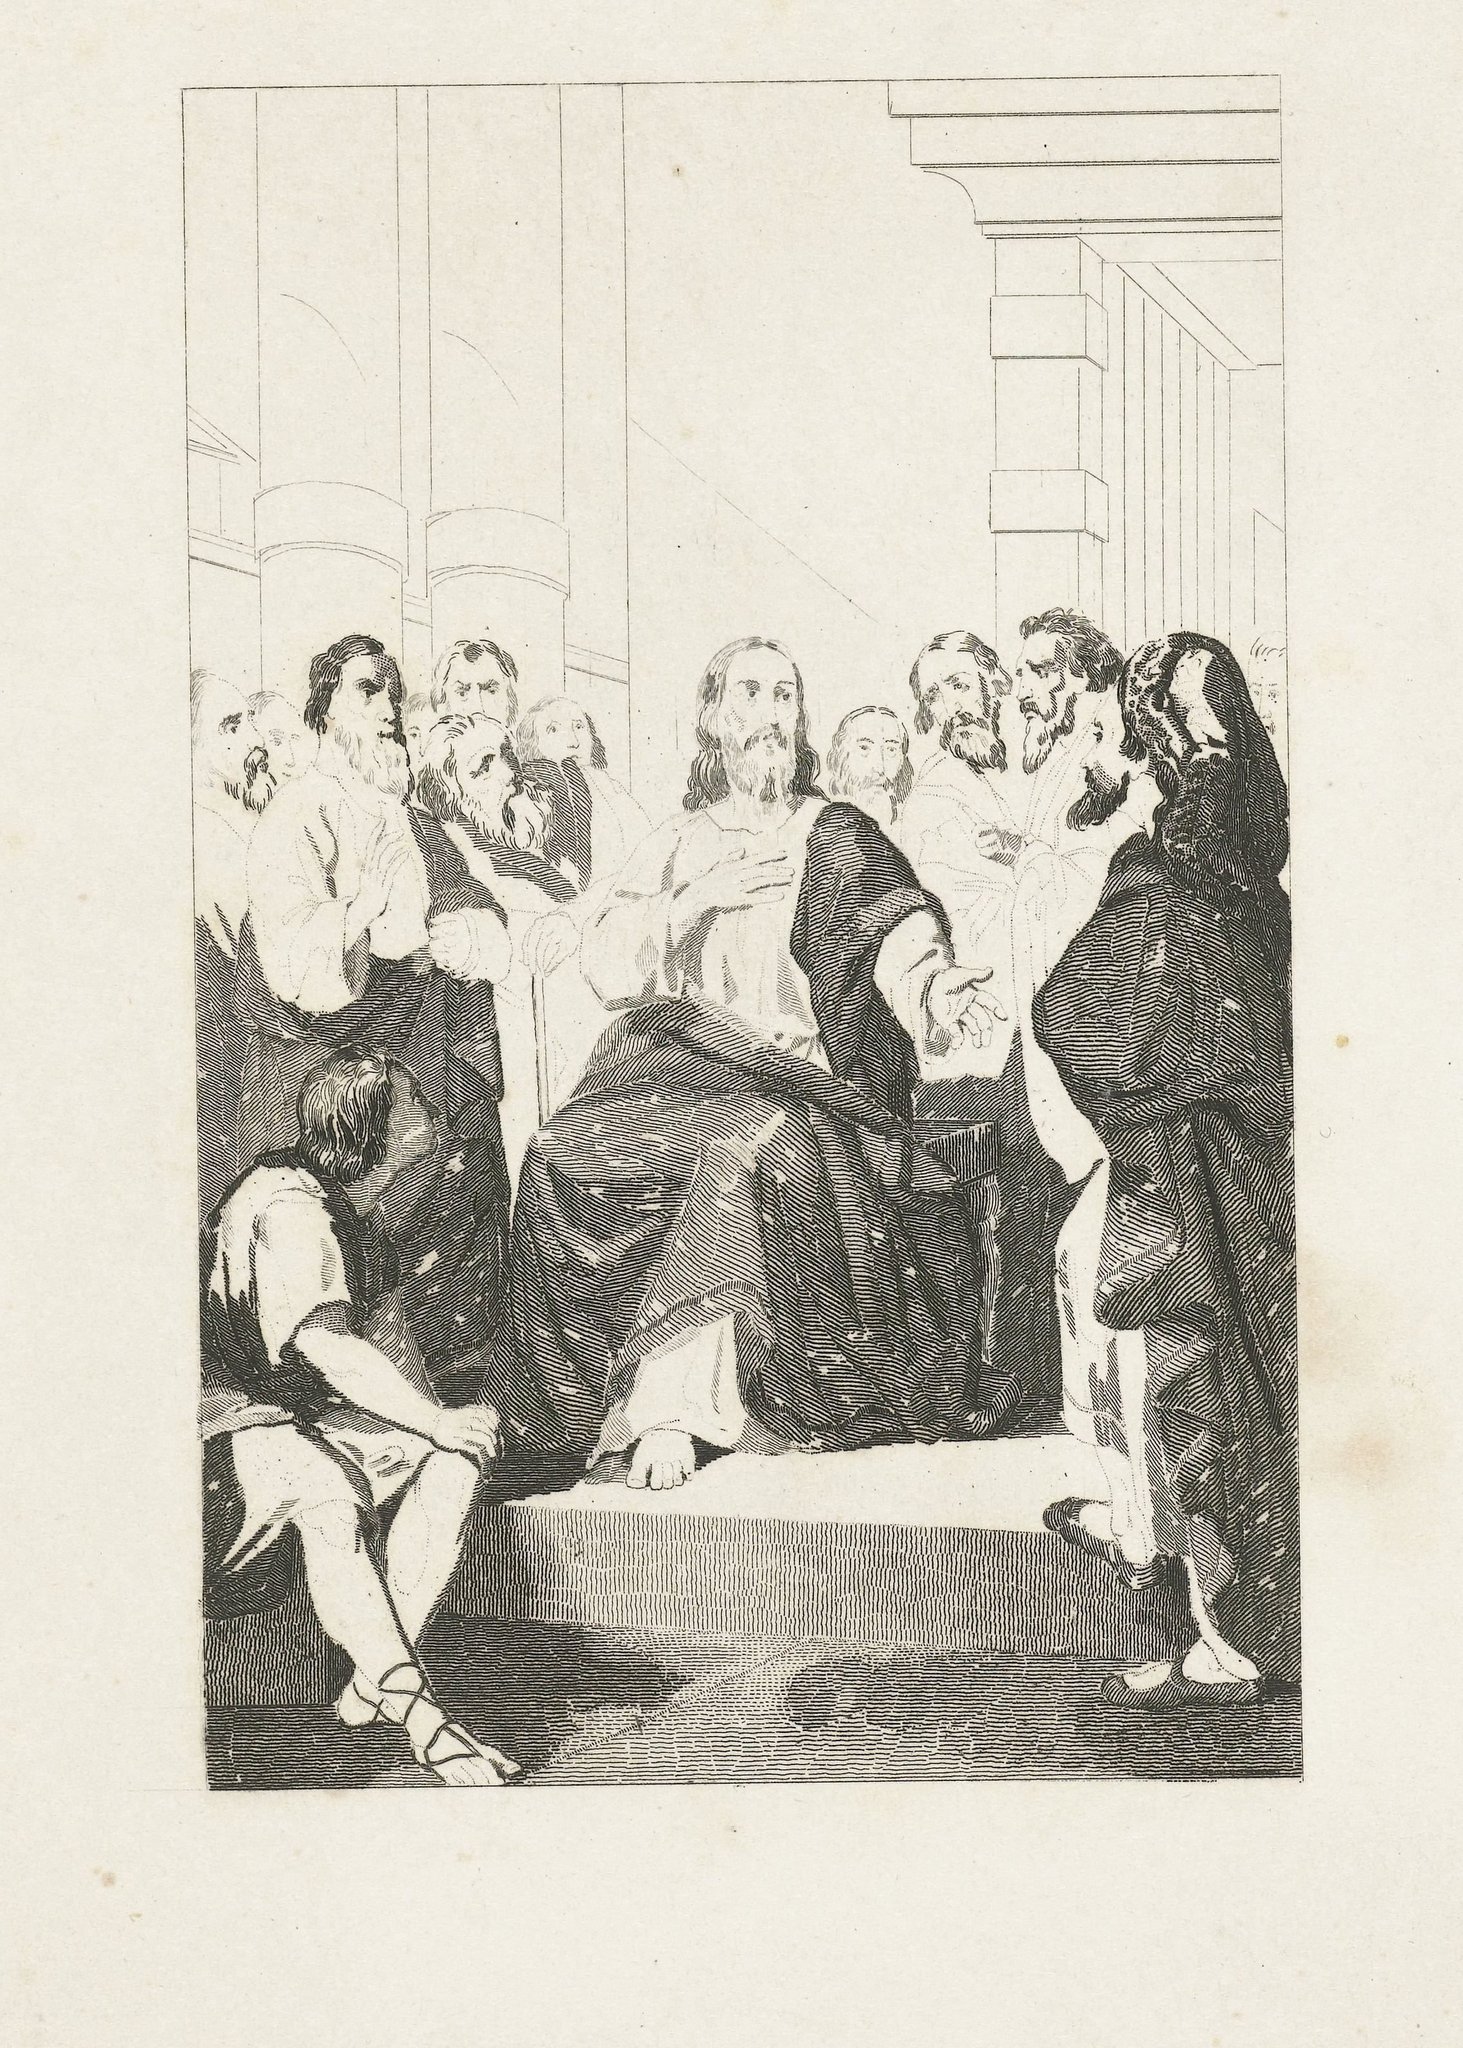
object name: print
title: Christus disputeert met mannen in de tempel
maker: henricus wilhelmus couwenberg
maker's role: draughtsman, print maker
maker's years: 1814-1845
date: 1830-1840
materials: paper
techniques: engraving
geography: amsterdam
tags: christ explaining his doctrine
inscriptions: collector's mark: Lugt 2228